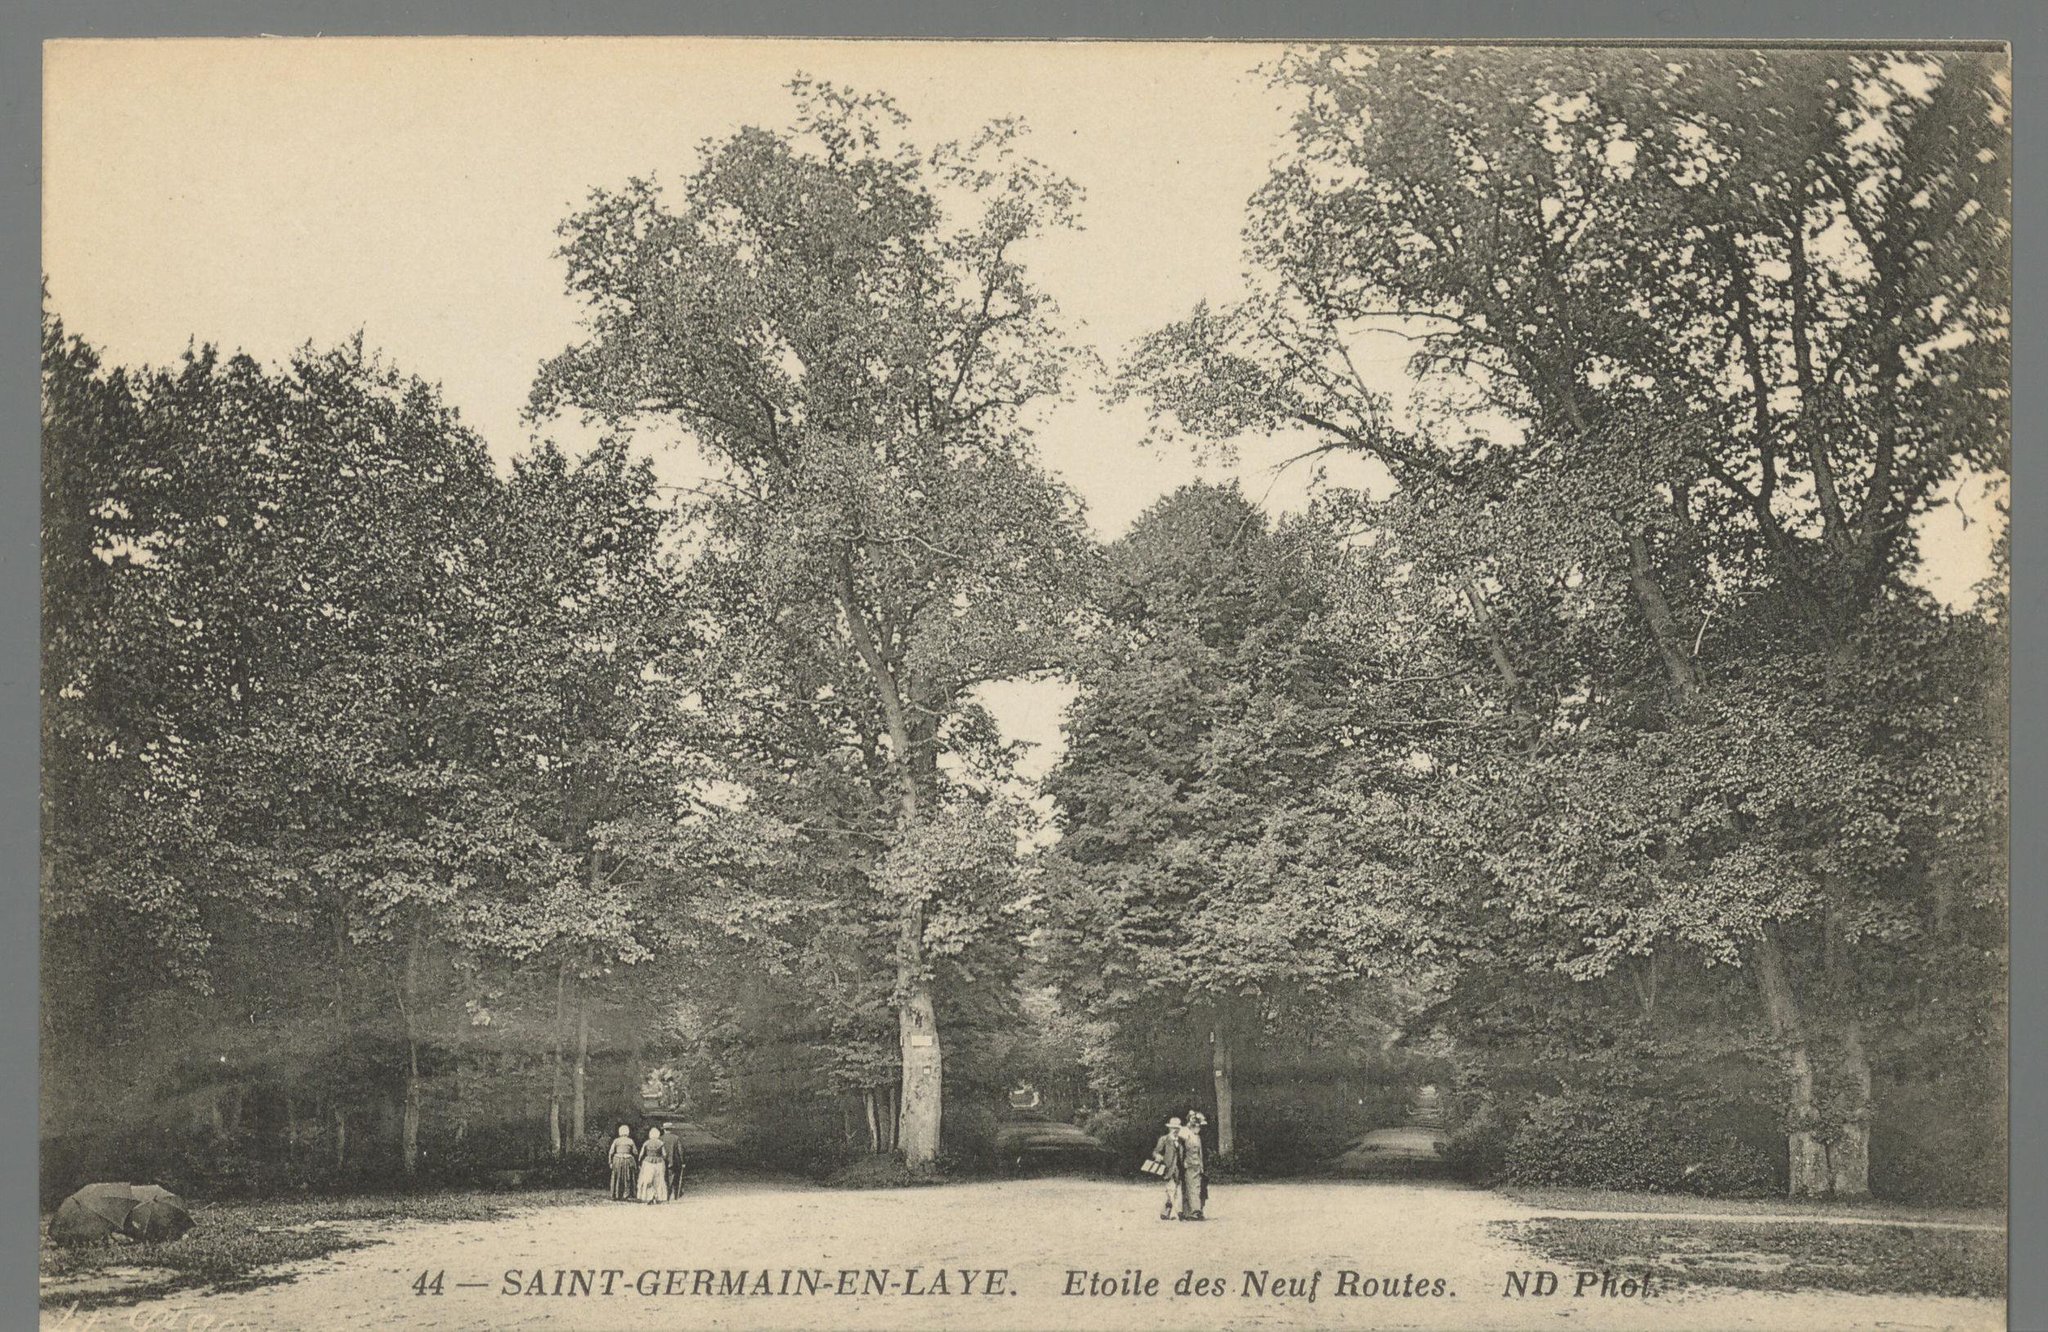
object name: photomechanical print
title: Saint-Germain-en-Laye. Etoile des Neuf Routes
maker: Anonymous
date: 1903-1918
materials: cardboard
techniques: photograph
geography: saint-germain-en-laye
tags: park, strolling